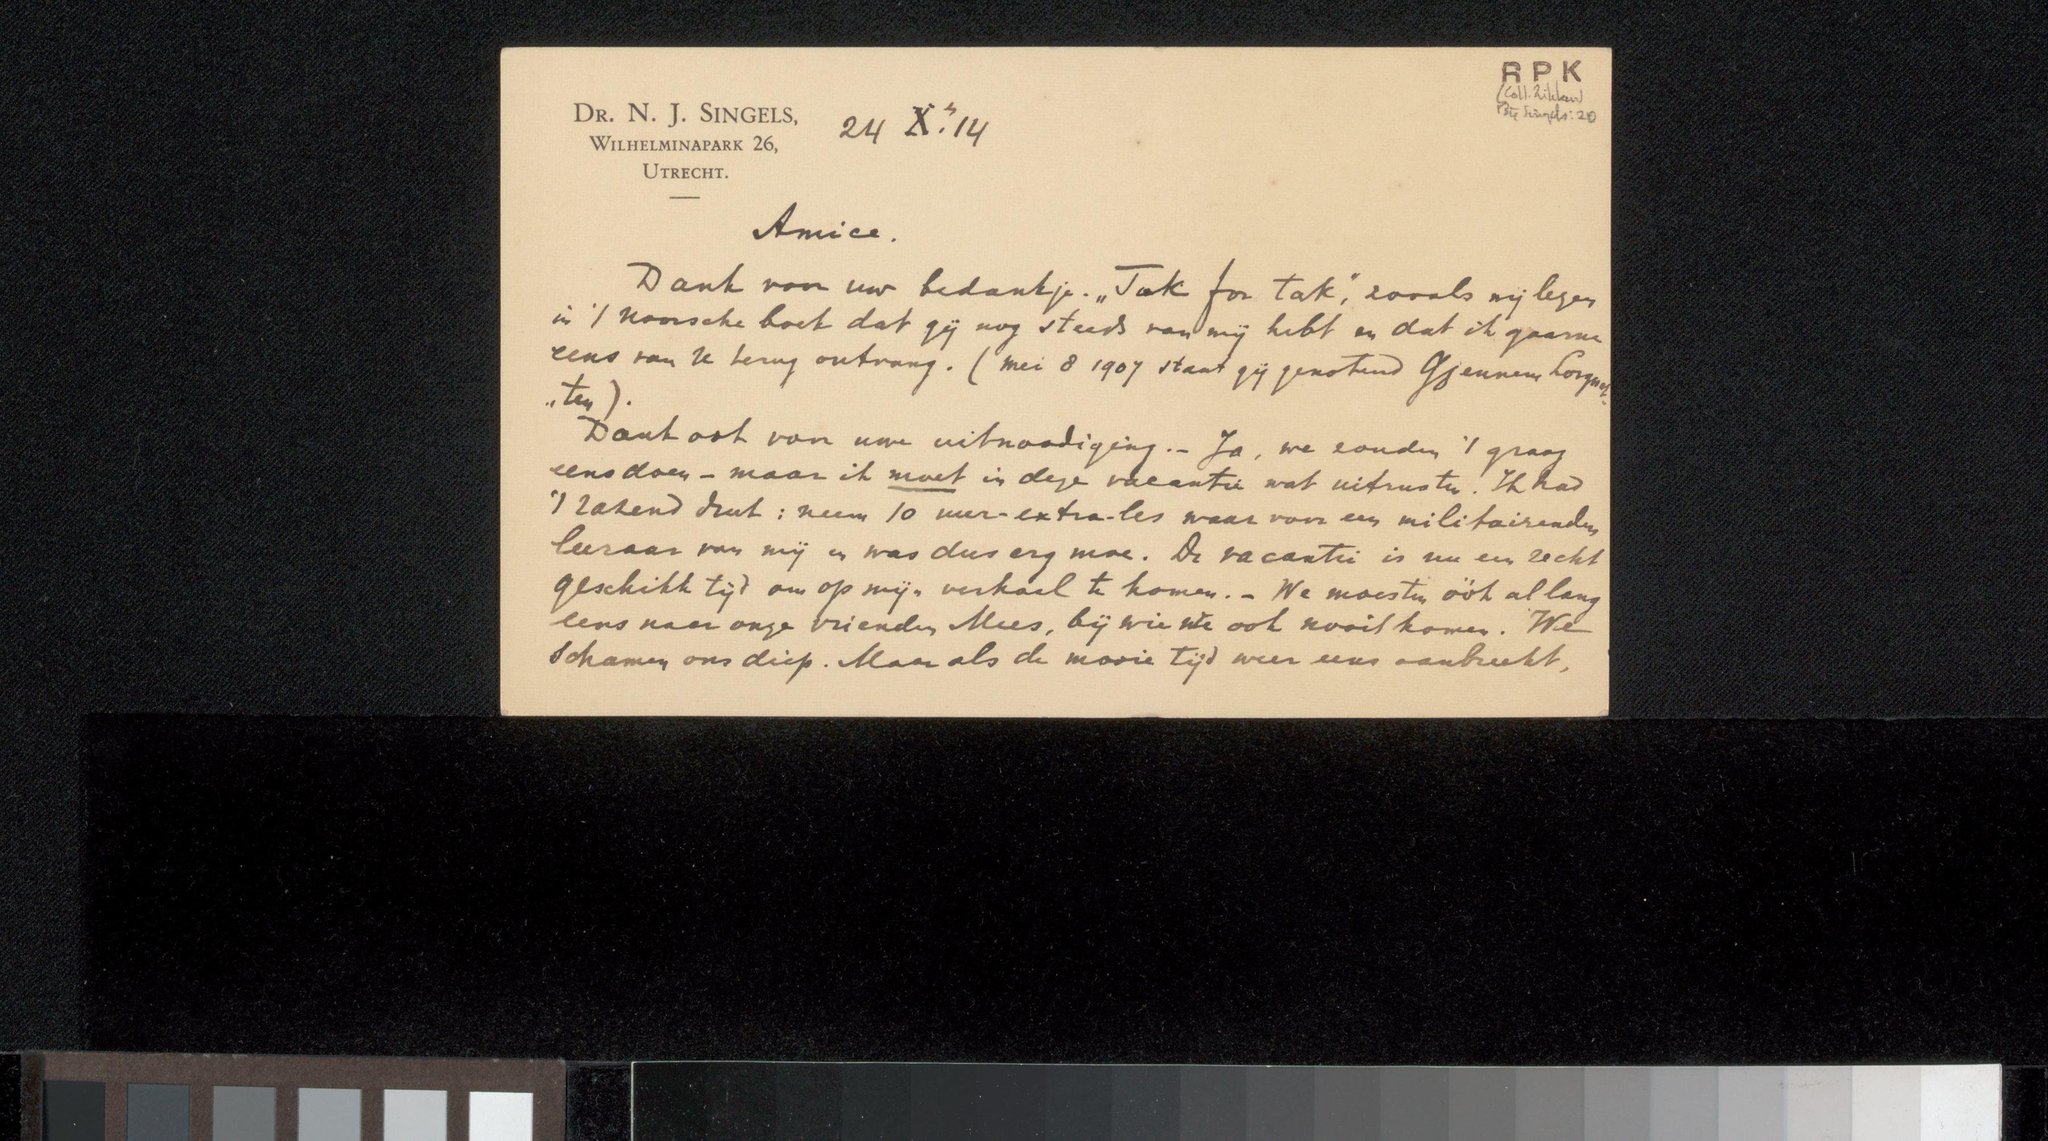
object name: letter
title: Brief aan Philip Zilcken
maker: n.j. singels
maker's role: leraar, schrijver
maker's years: 1857-1931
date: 1914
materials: cardboard, ink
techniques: pen, printing, writing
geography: utrecht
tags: amsterdam, utrecht, print maker, elisabeth adriani-hovy, the hague, painter, philip zilcken, drawing, exhibition ~ art, printed matter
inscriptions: collector's mark: ‘RPK’